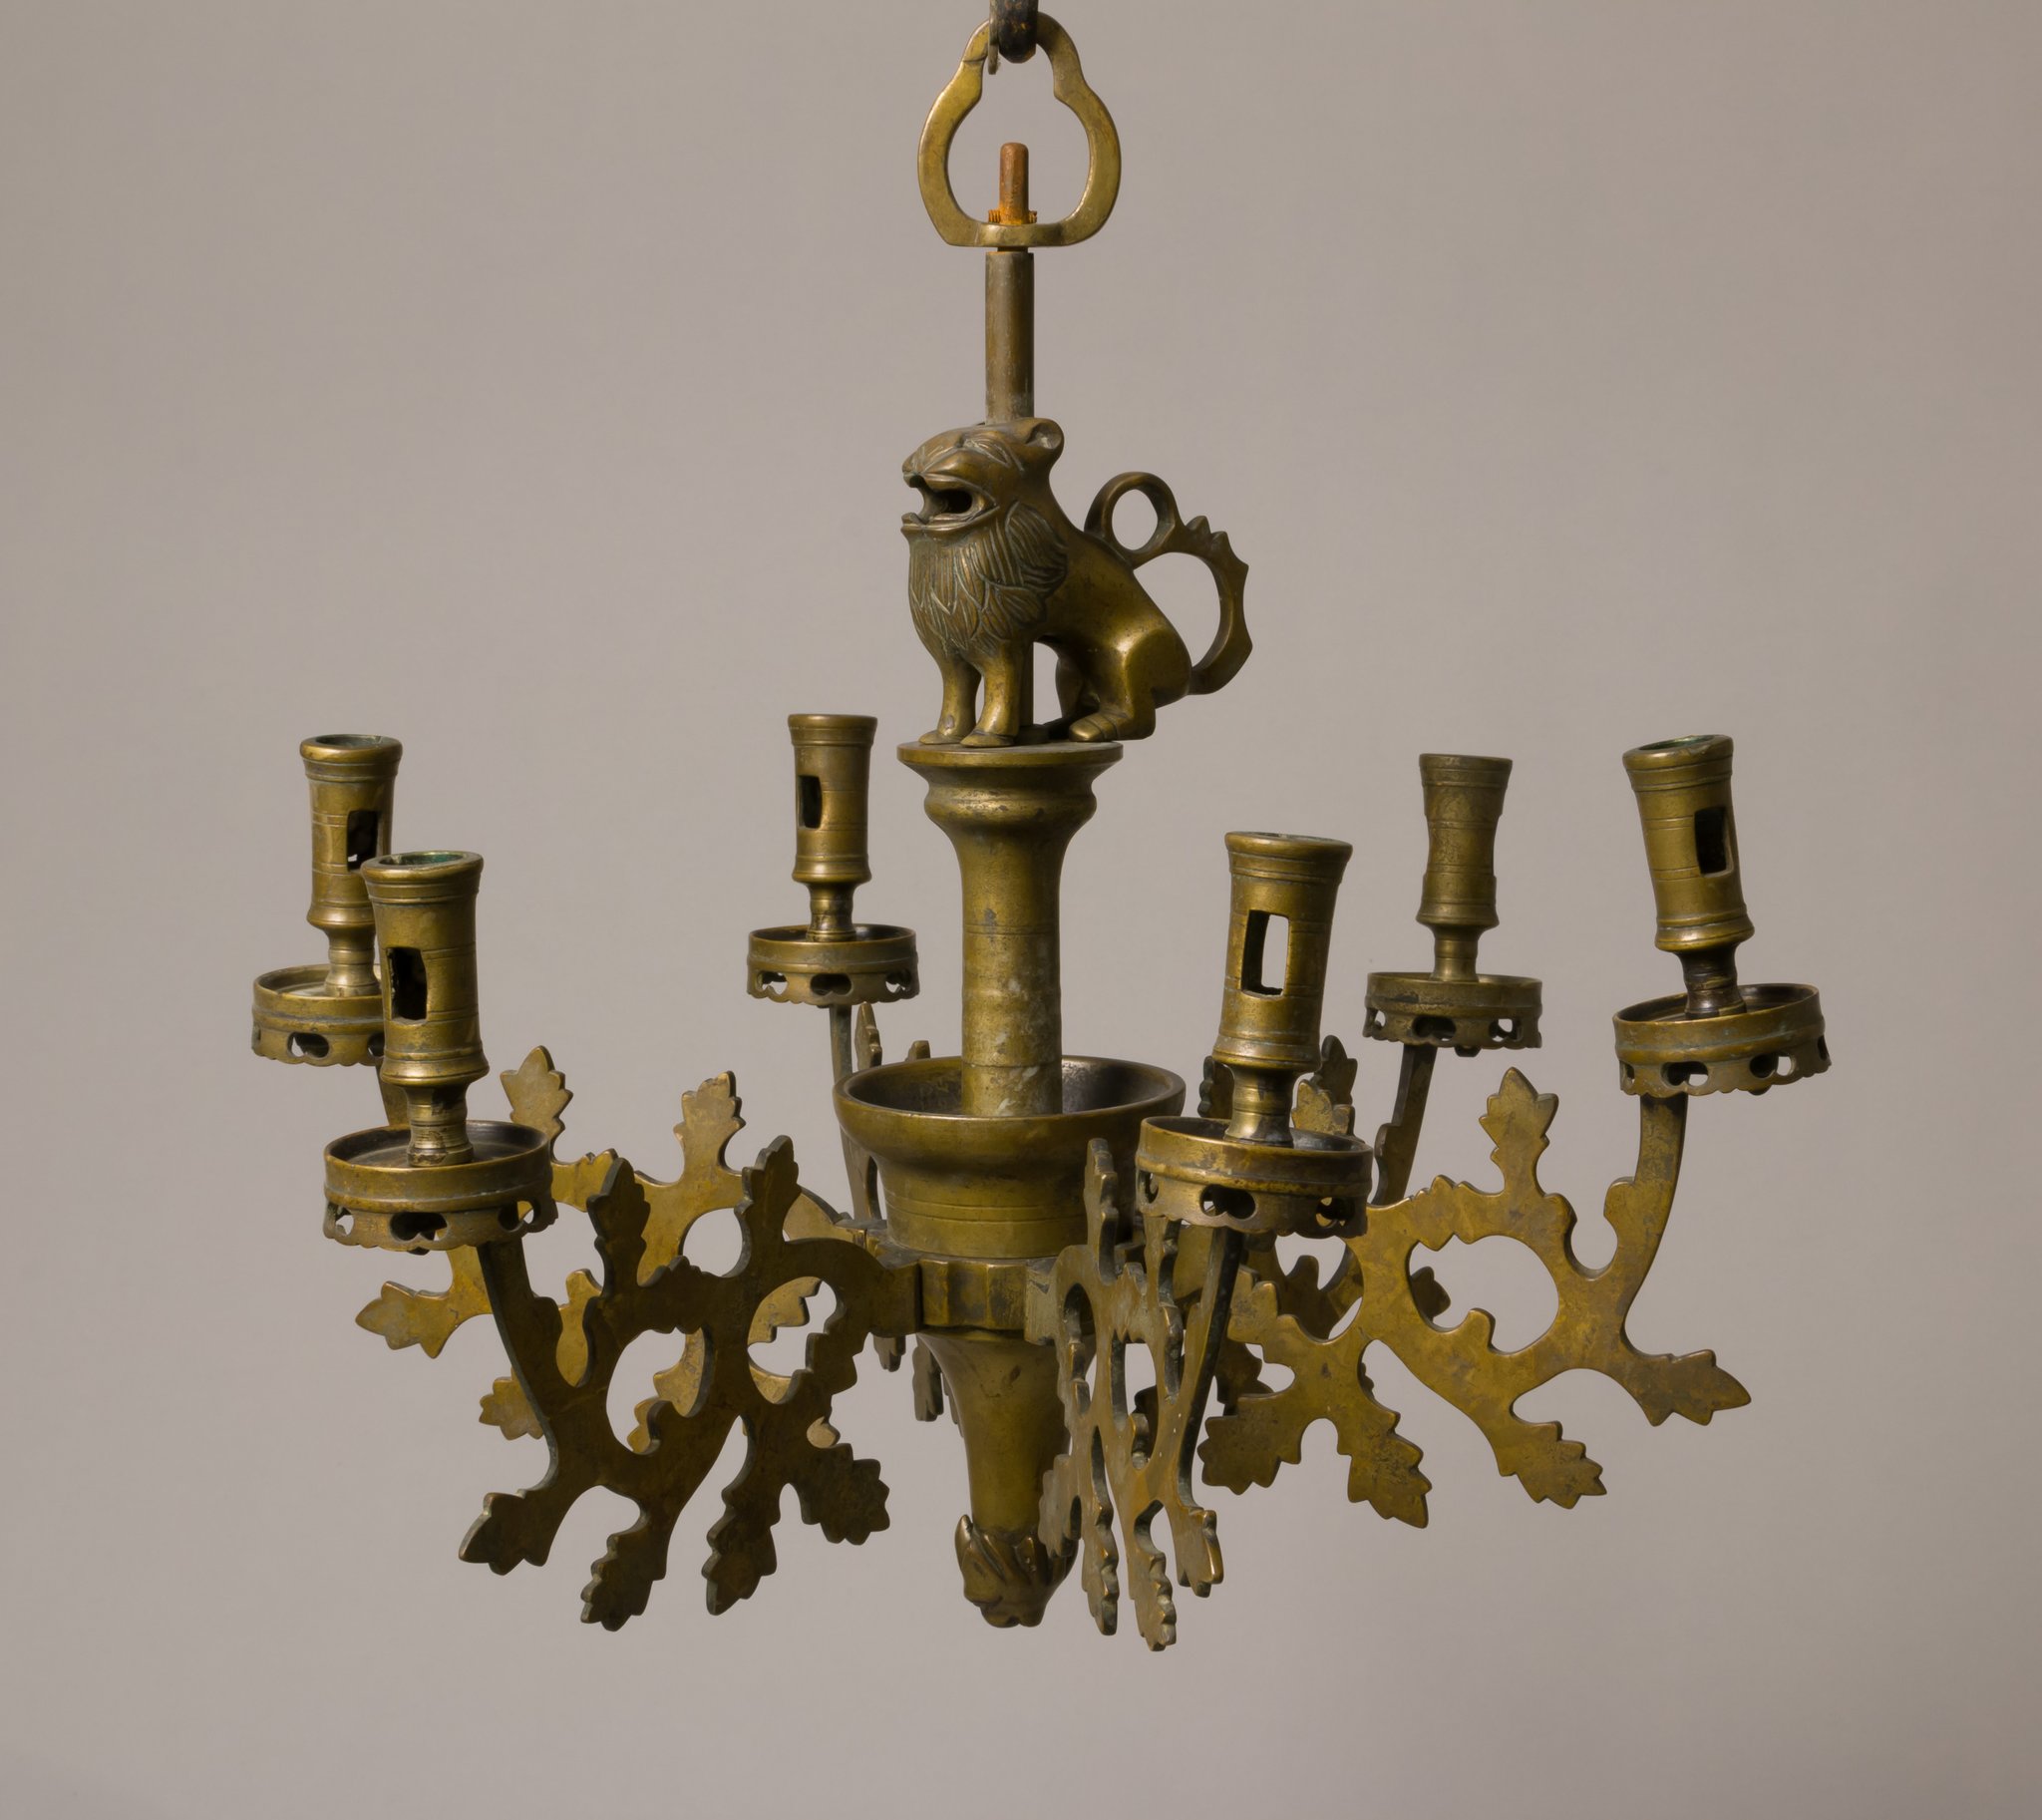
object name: chandelier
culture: south netherlandish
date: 1434-1466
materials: brass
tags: animals